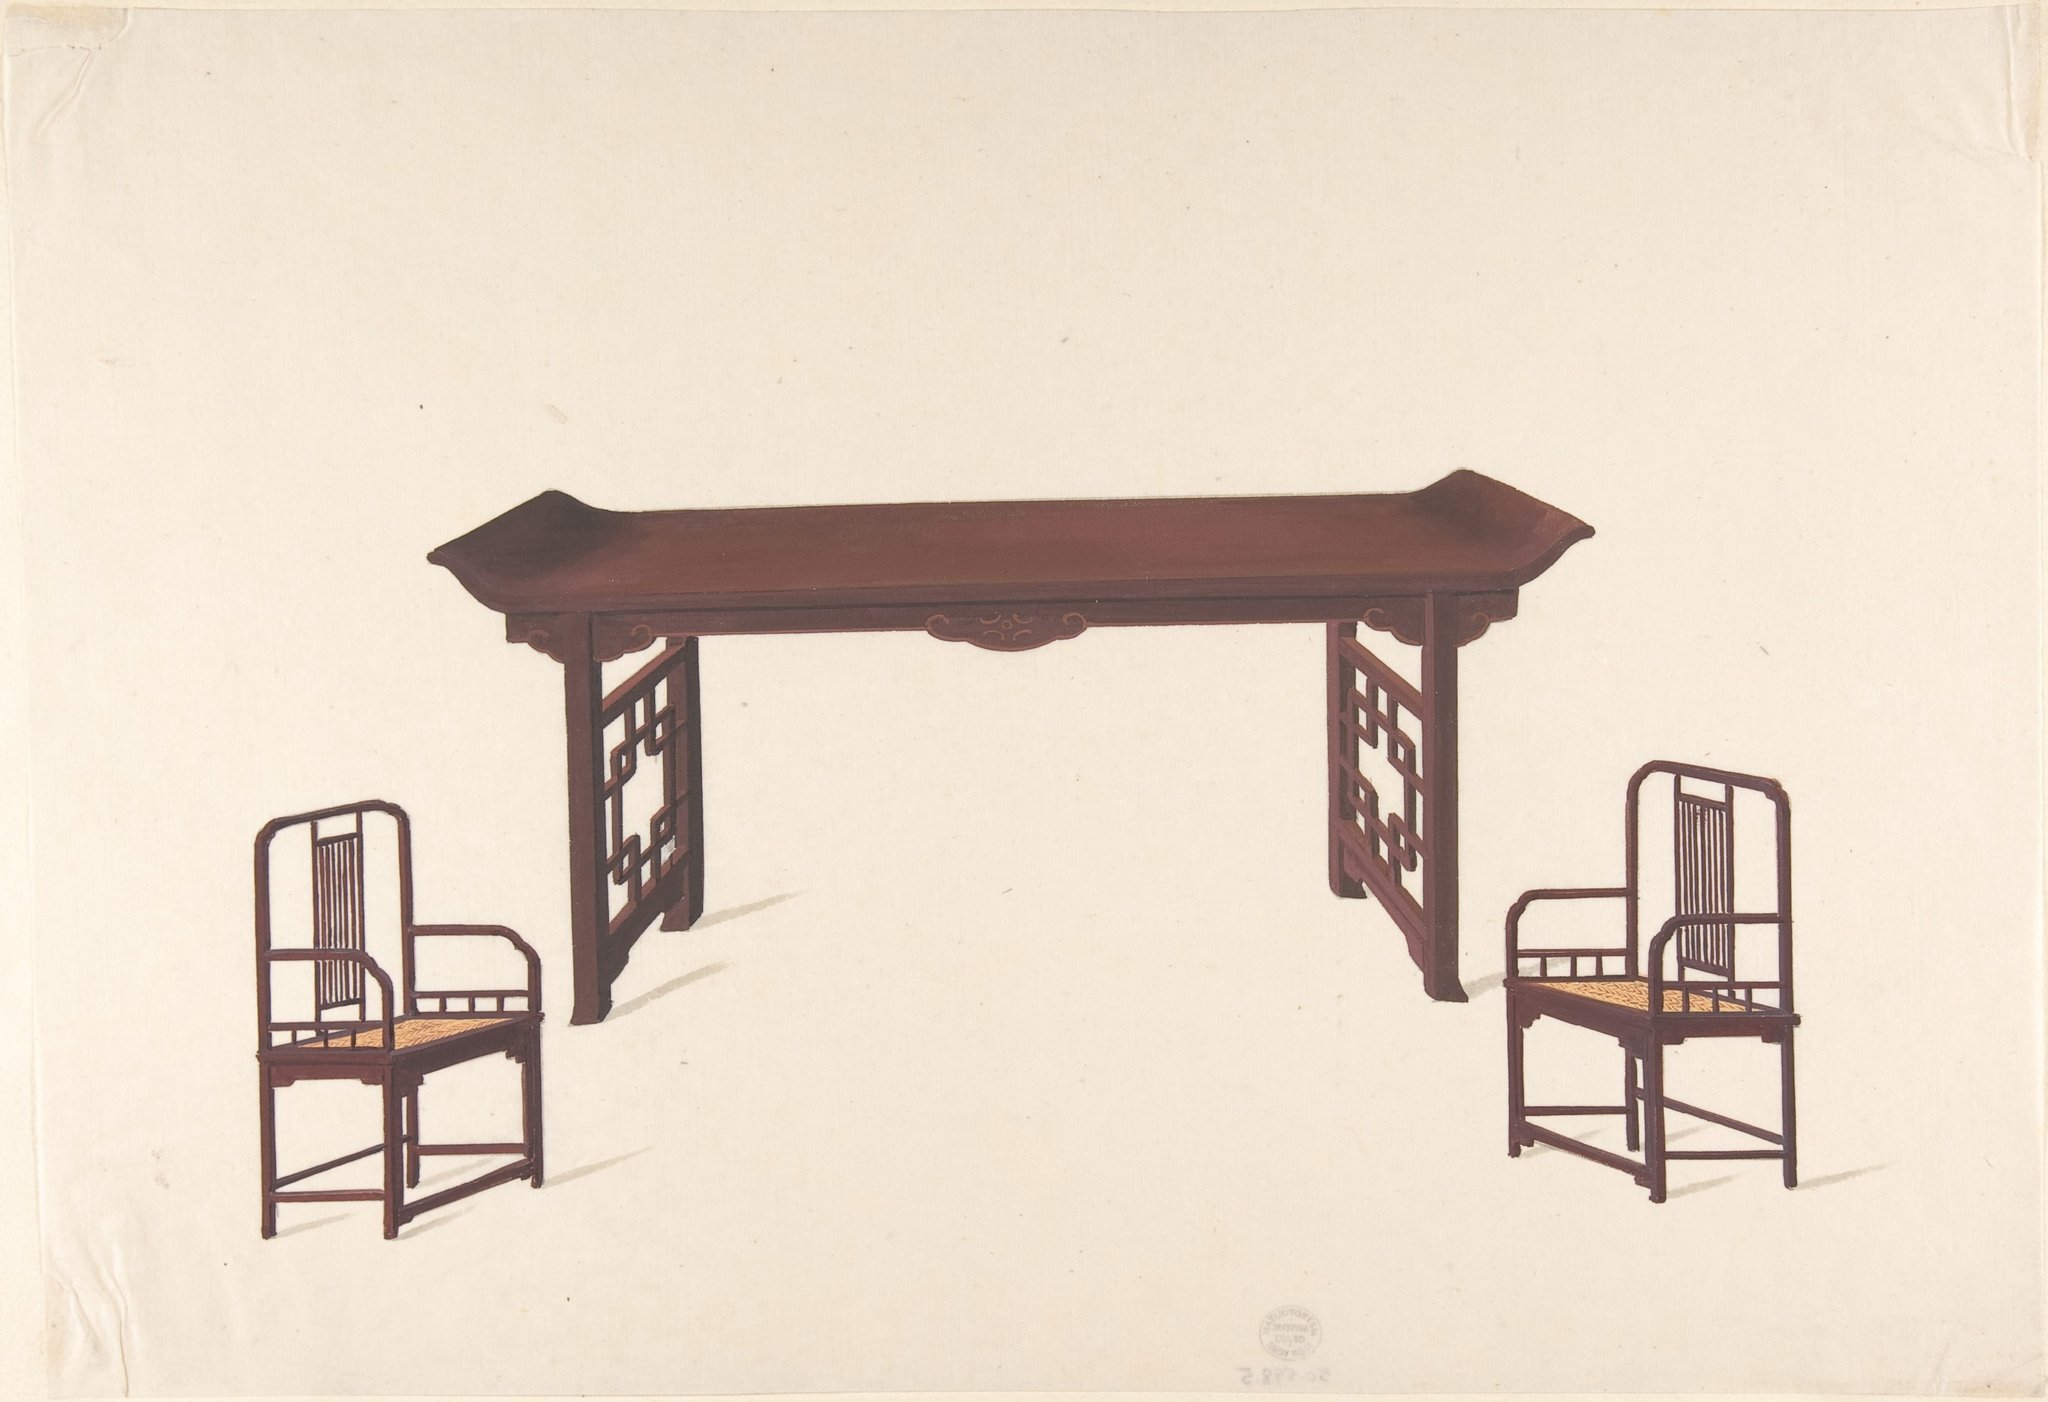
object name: drawing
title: Design for Export Furniture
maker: anonymous, chinese, 19th century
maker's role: artist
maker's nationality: chinese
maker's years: 1800-1900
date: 1800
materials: graphite, watercolor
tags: chairs